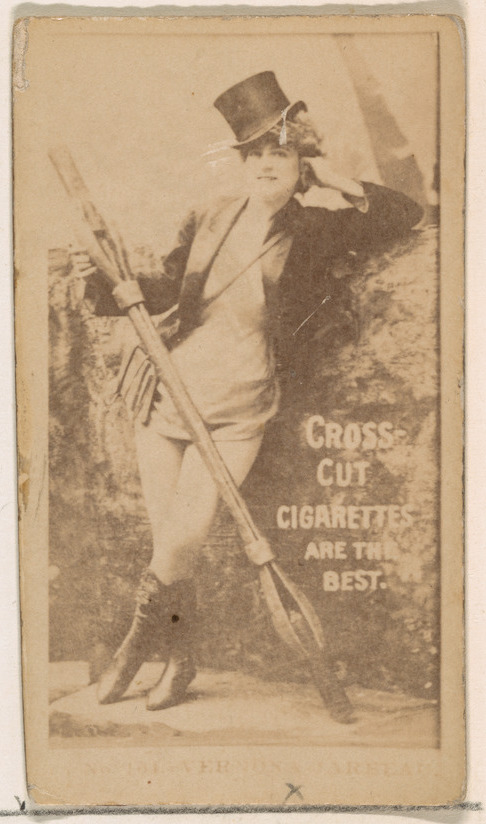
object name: print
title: Jarbeau, from the Actors and Actresses series (N145-2) issued by Duke Sons & Co. to promote Cross Cut Cigarettes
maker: w. duke, sons & co.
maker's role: publisher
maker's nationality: american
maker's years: 1870-1920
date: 1880-1889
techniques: albumen silver print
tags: portraits,women,actresses